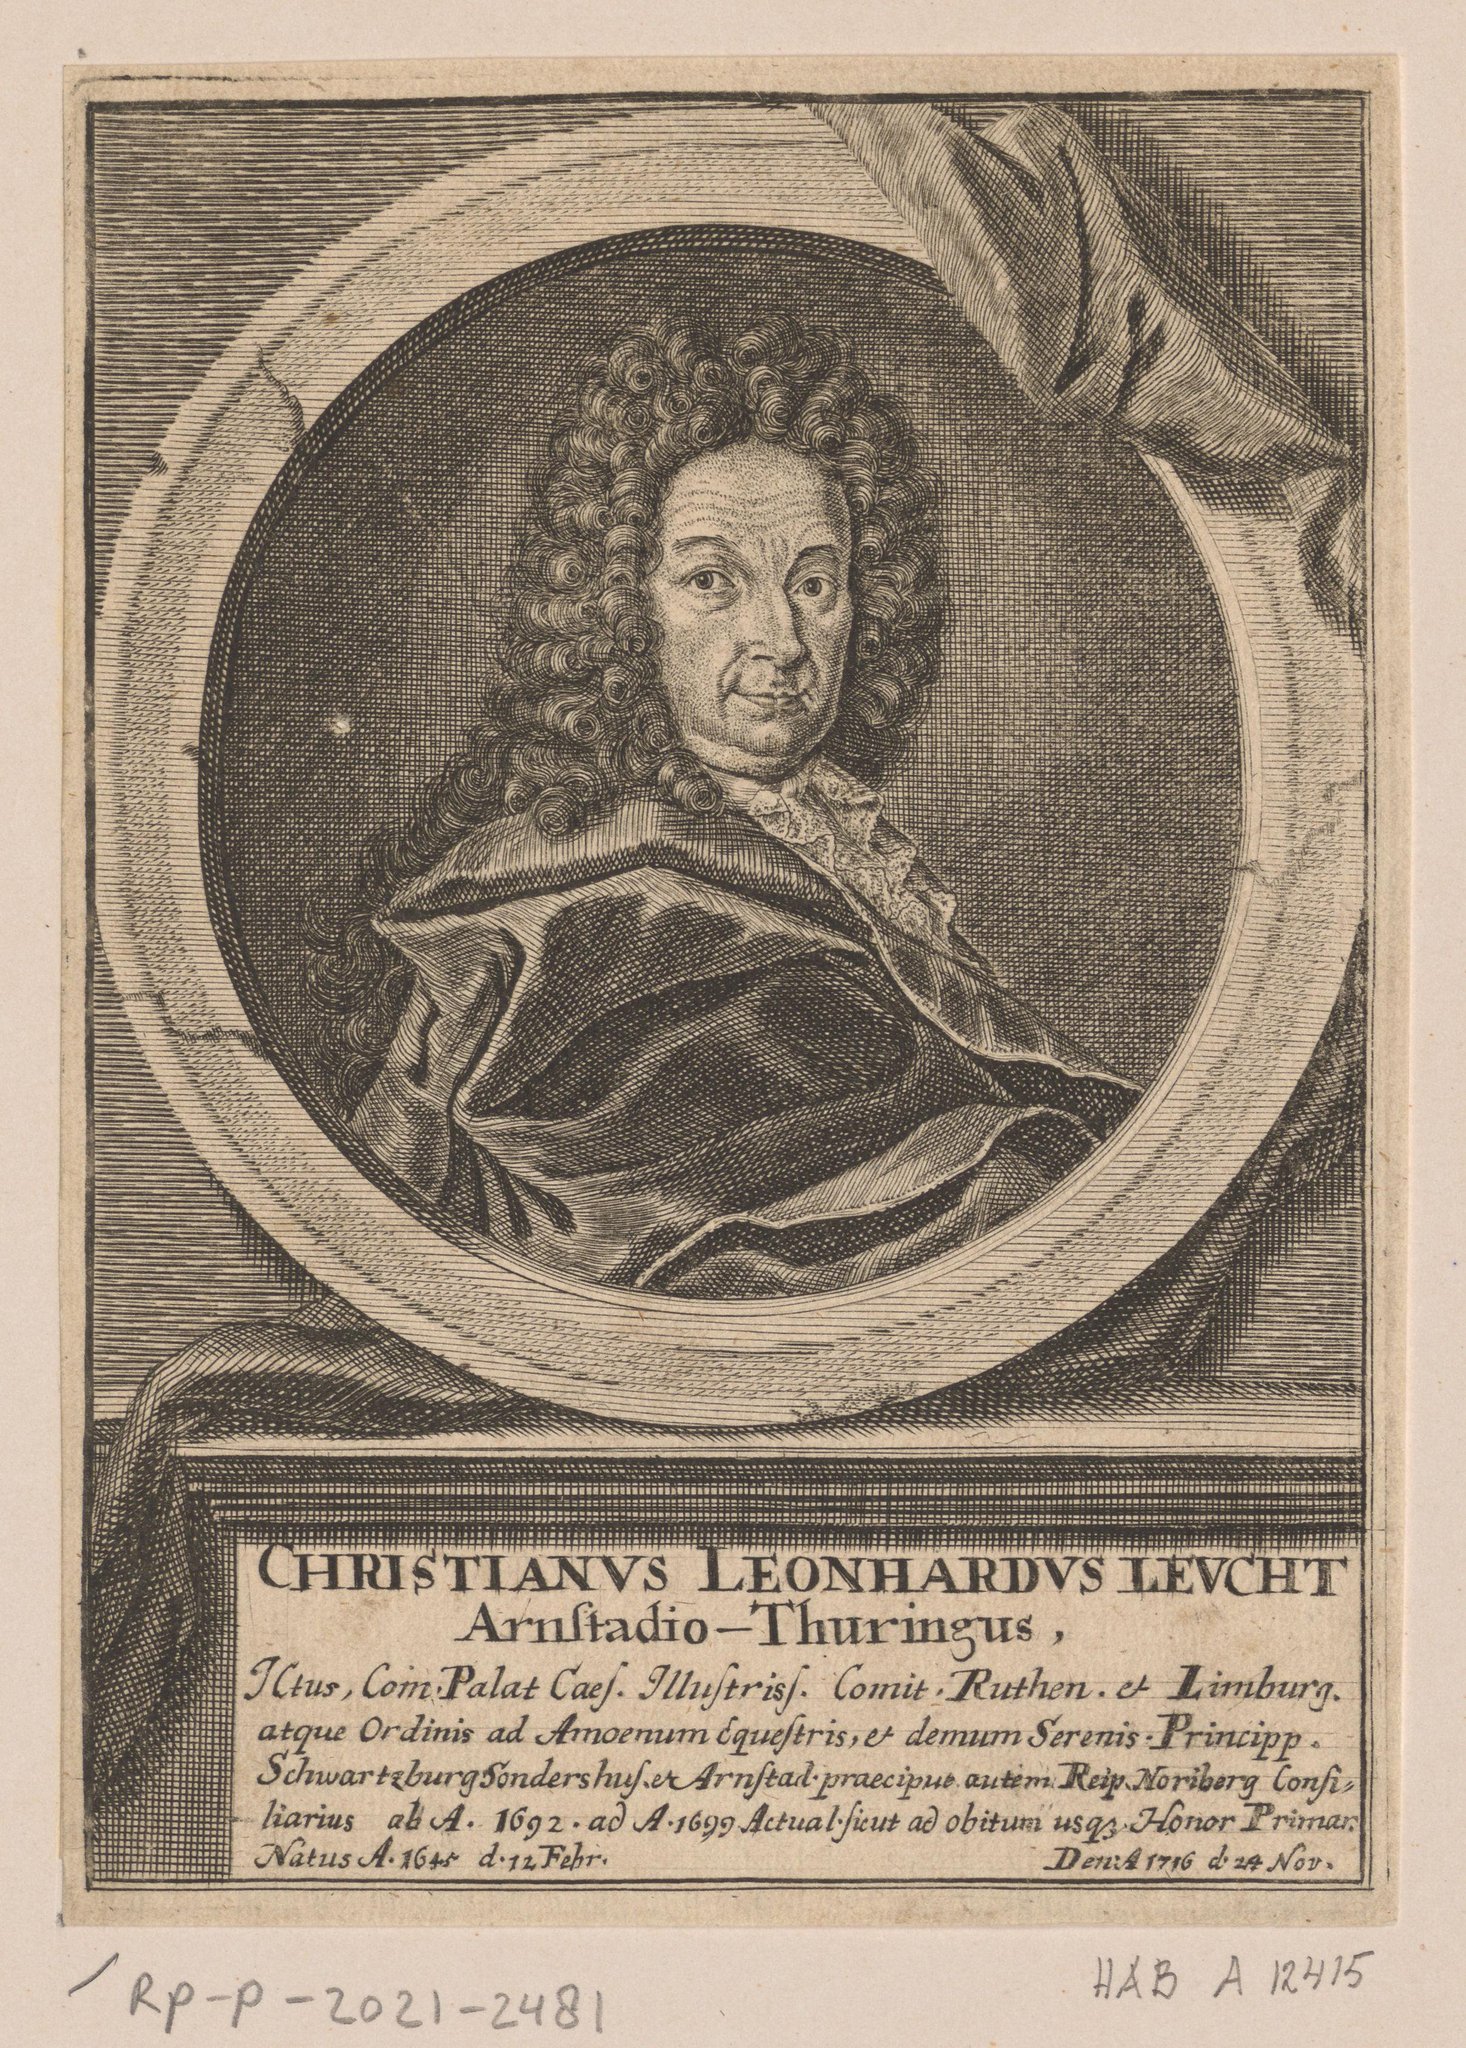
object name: print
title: Portret van Christian Leonhard Leucht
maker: Anonymous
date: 1716-1730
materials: paper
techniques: engraving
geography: germany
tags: ornament ~ medallion, historical persons